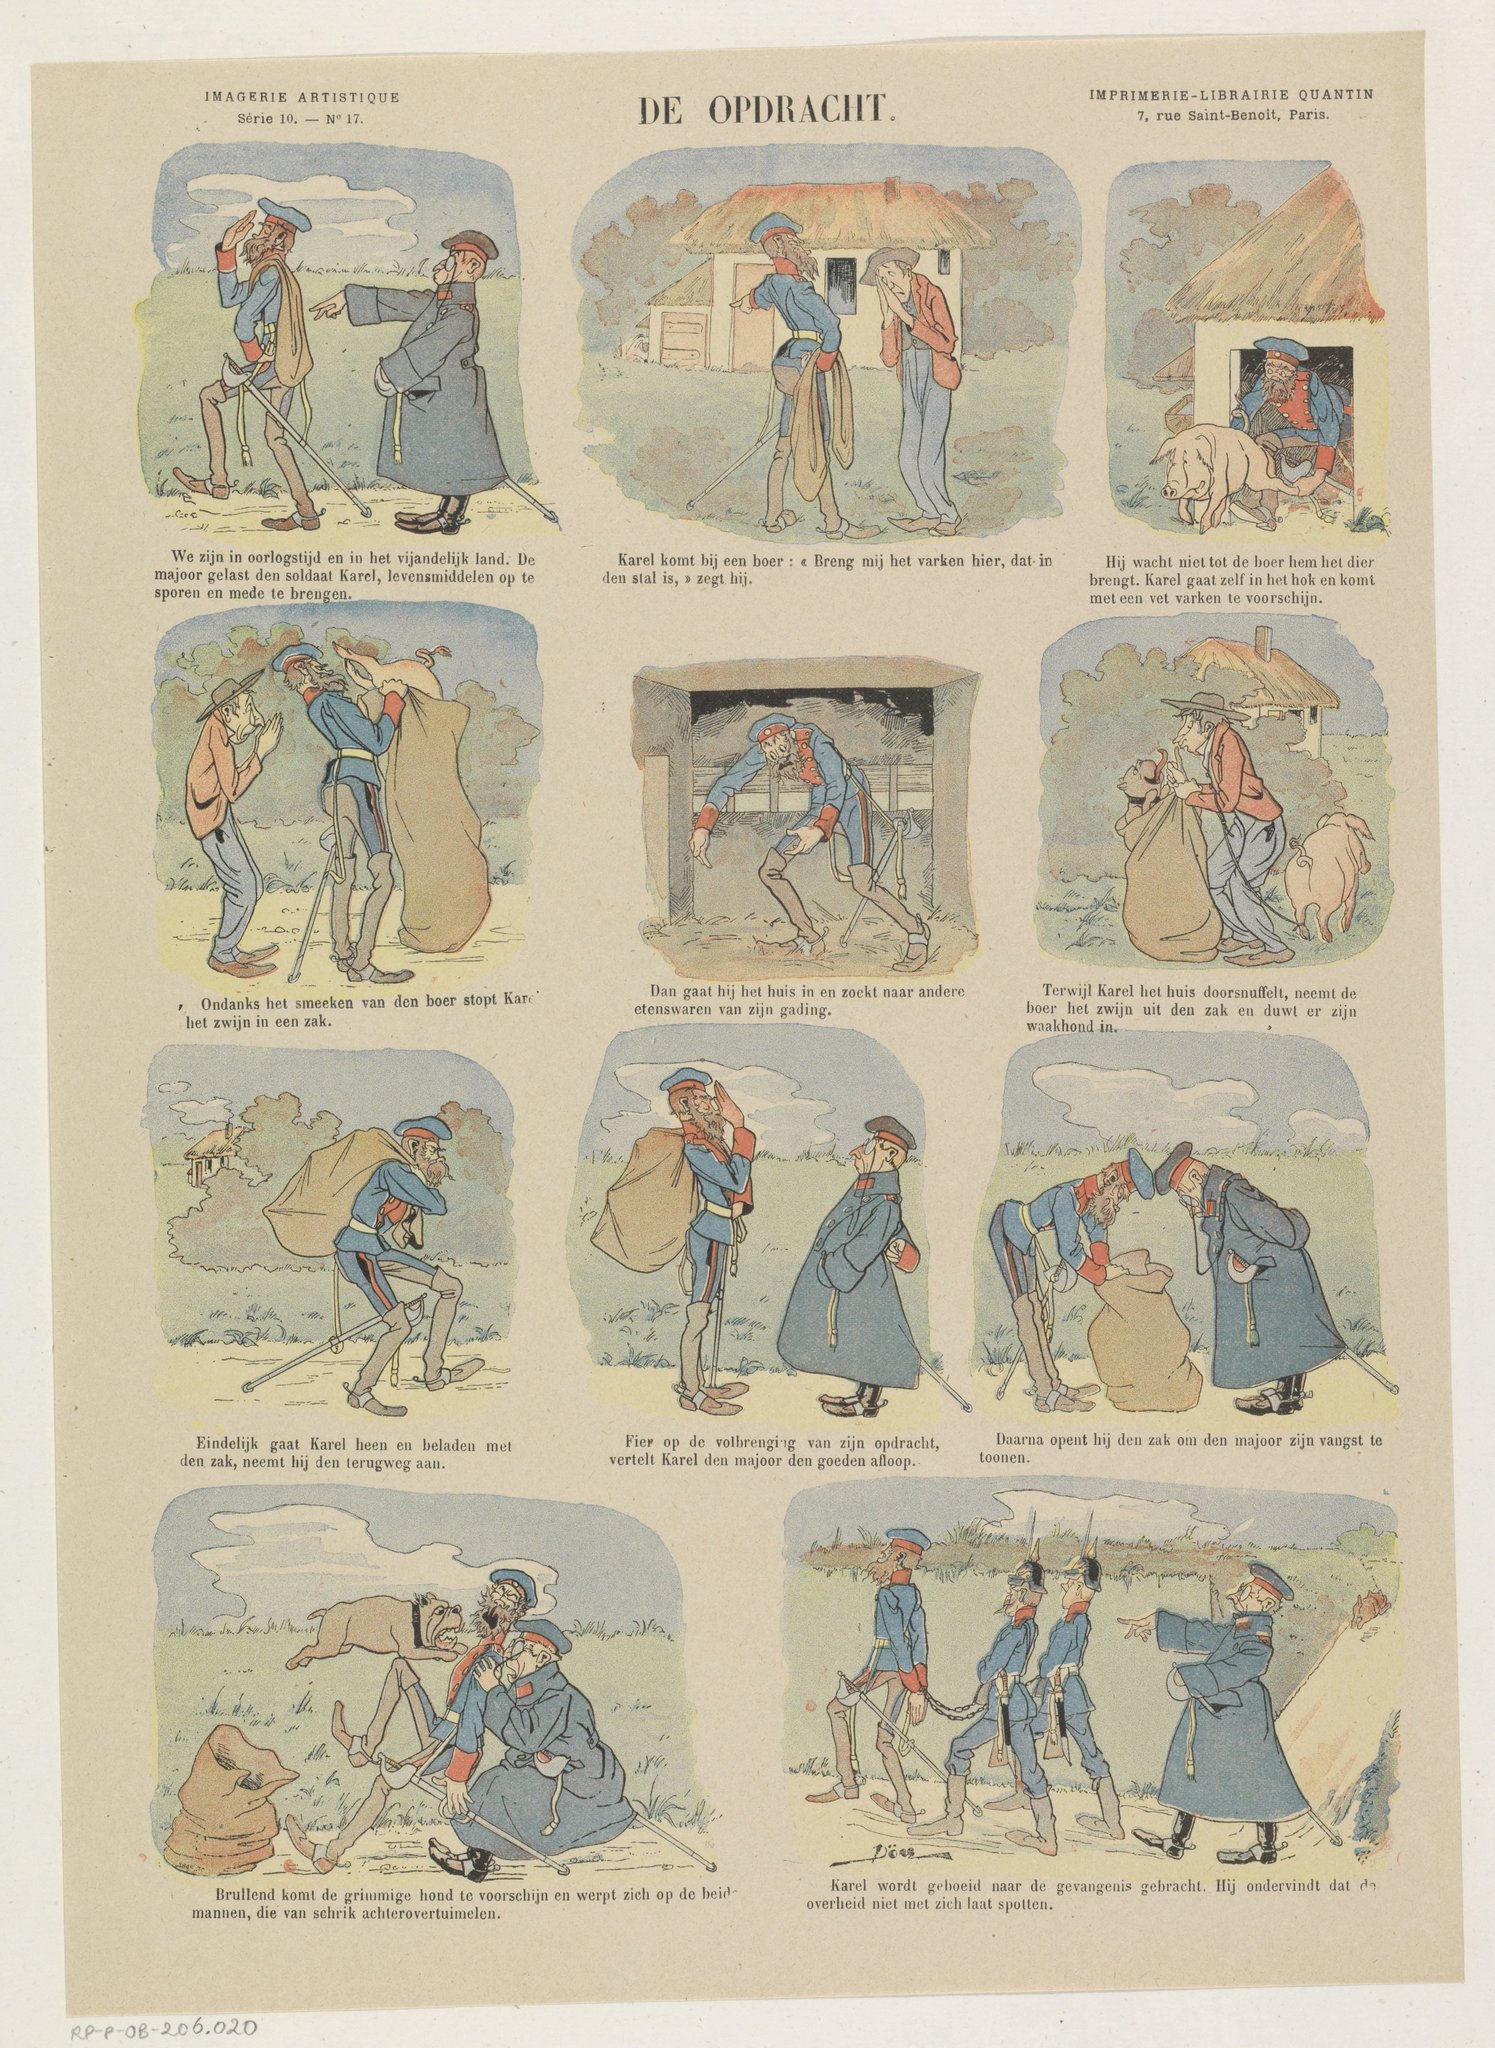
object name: print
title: De opdracht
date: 1876-1890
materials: paper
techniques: lithograph, letterpress printing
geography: paris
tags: pig, farmers, watch-dog, dog watching, tales and fairy tales, the soldier; the soldier's life, handcuffs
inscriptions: collector's mark: Lugt 2760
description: Blad met 11 voorstellingen van soldaat Karel die op pad wordt gestuurd om levensmiddelen te halen. Hij denkt een varken in zijn zak te hebben, maar de boer heeft het varken vervangen door zijn waakhond. Onder elke afbeelding een onderschrift. Genummerd linksboven: Série 10. - No. 17.